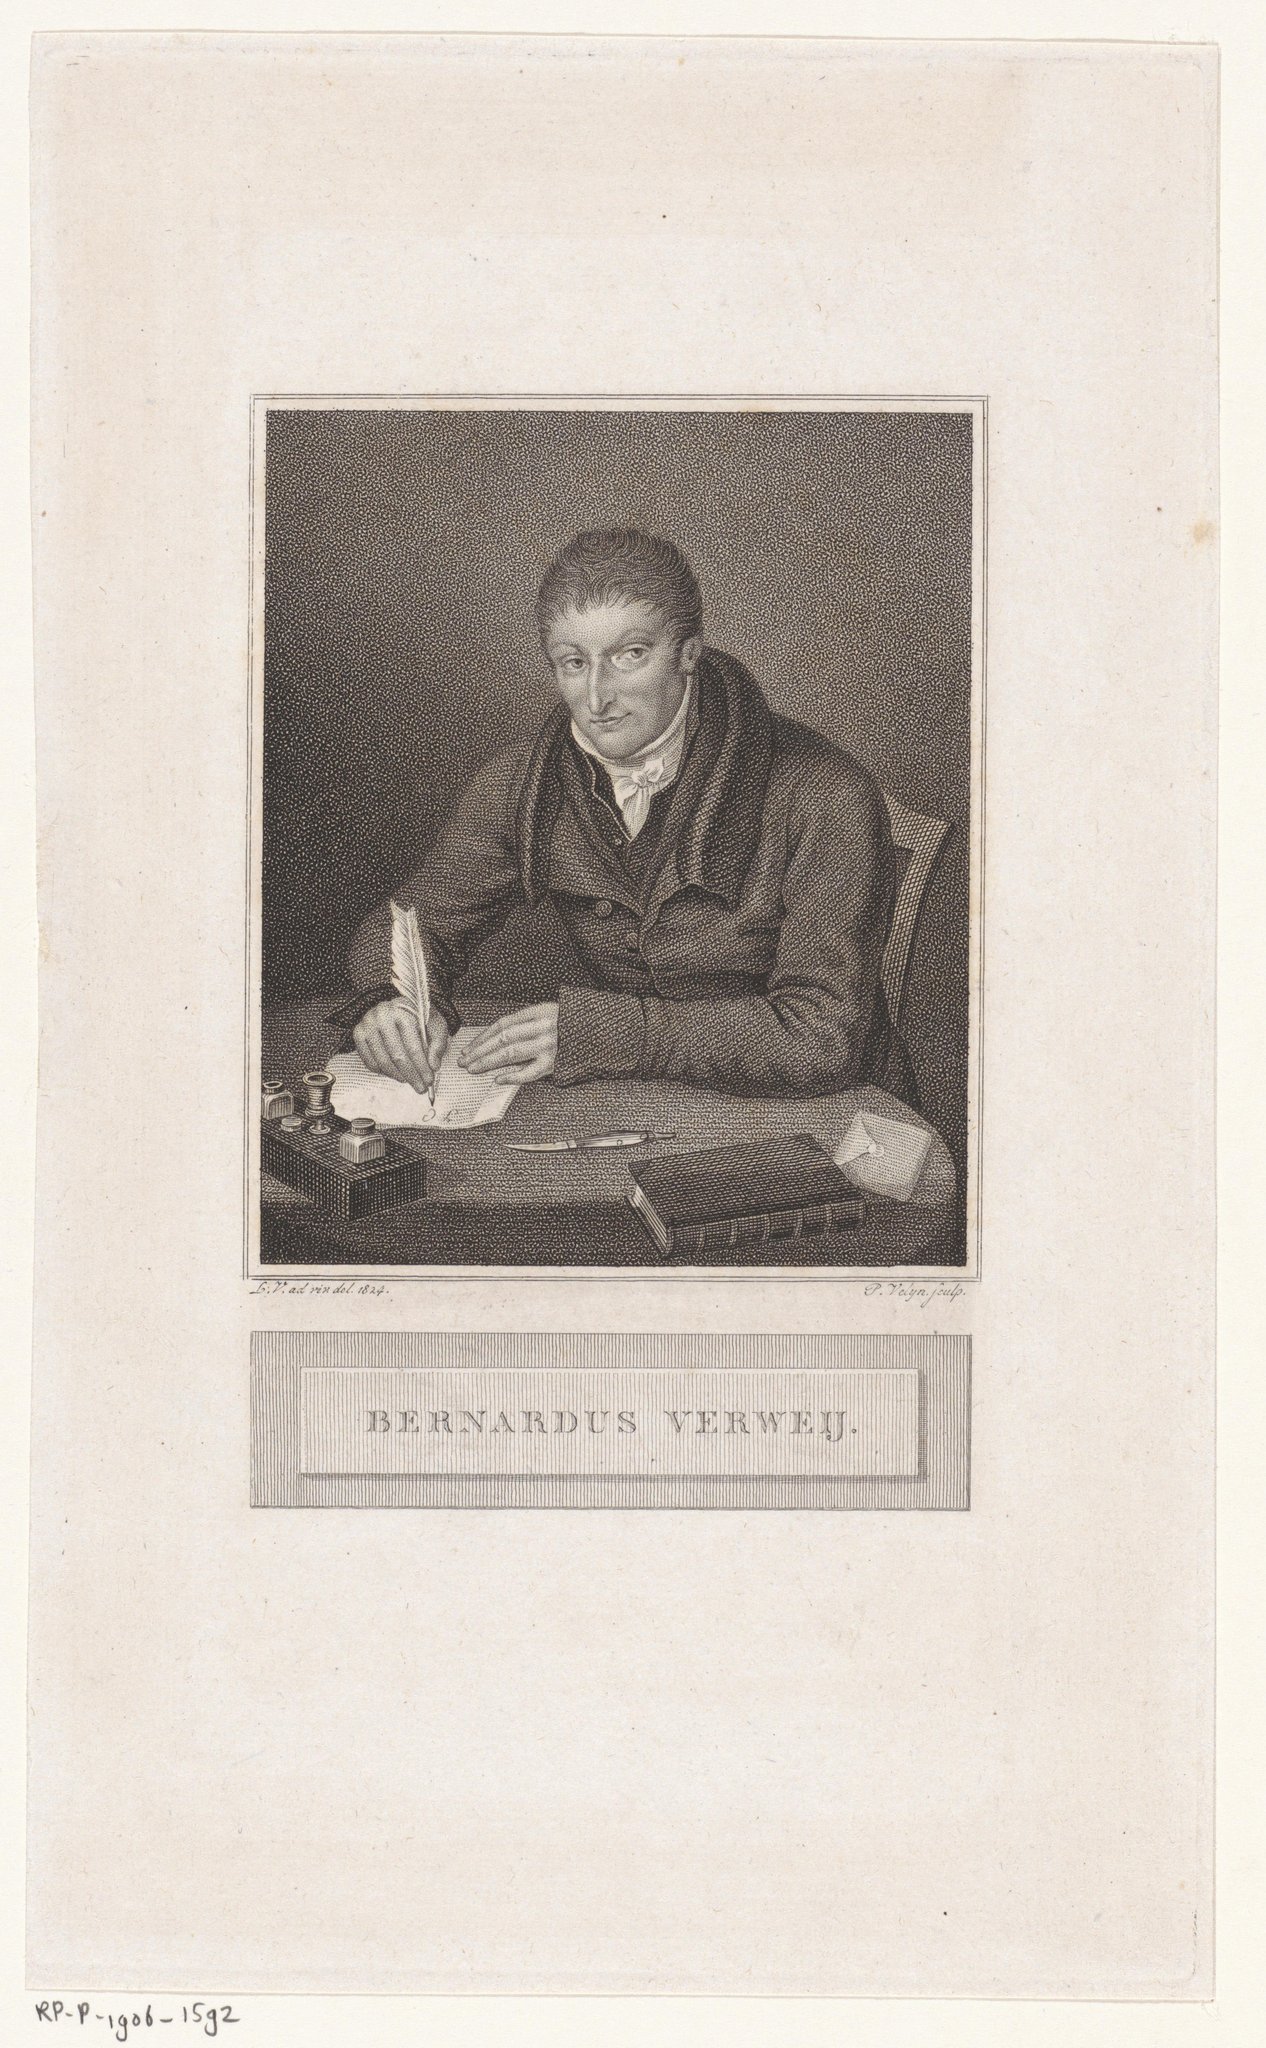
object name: print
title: Portret van Bernardus Verwey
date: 1824-1836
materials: paper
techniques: engraving, etching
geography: netherlands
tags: writing-table, writing-desk, writing accessories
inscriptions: collector's mark: Lugt 2228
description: Portret van de predikant Bernardus Verwey aan een schrijftafel.